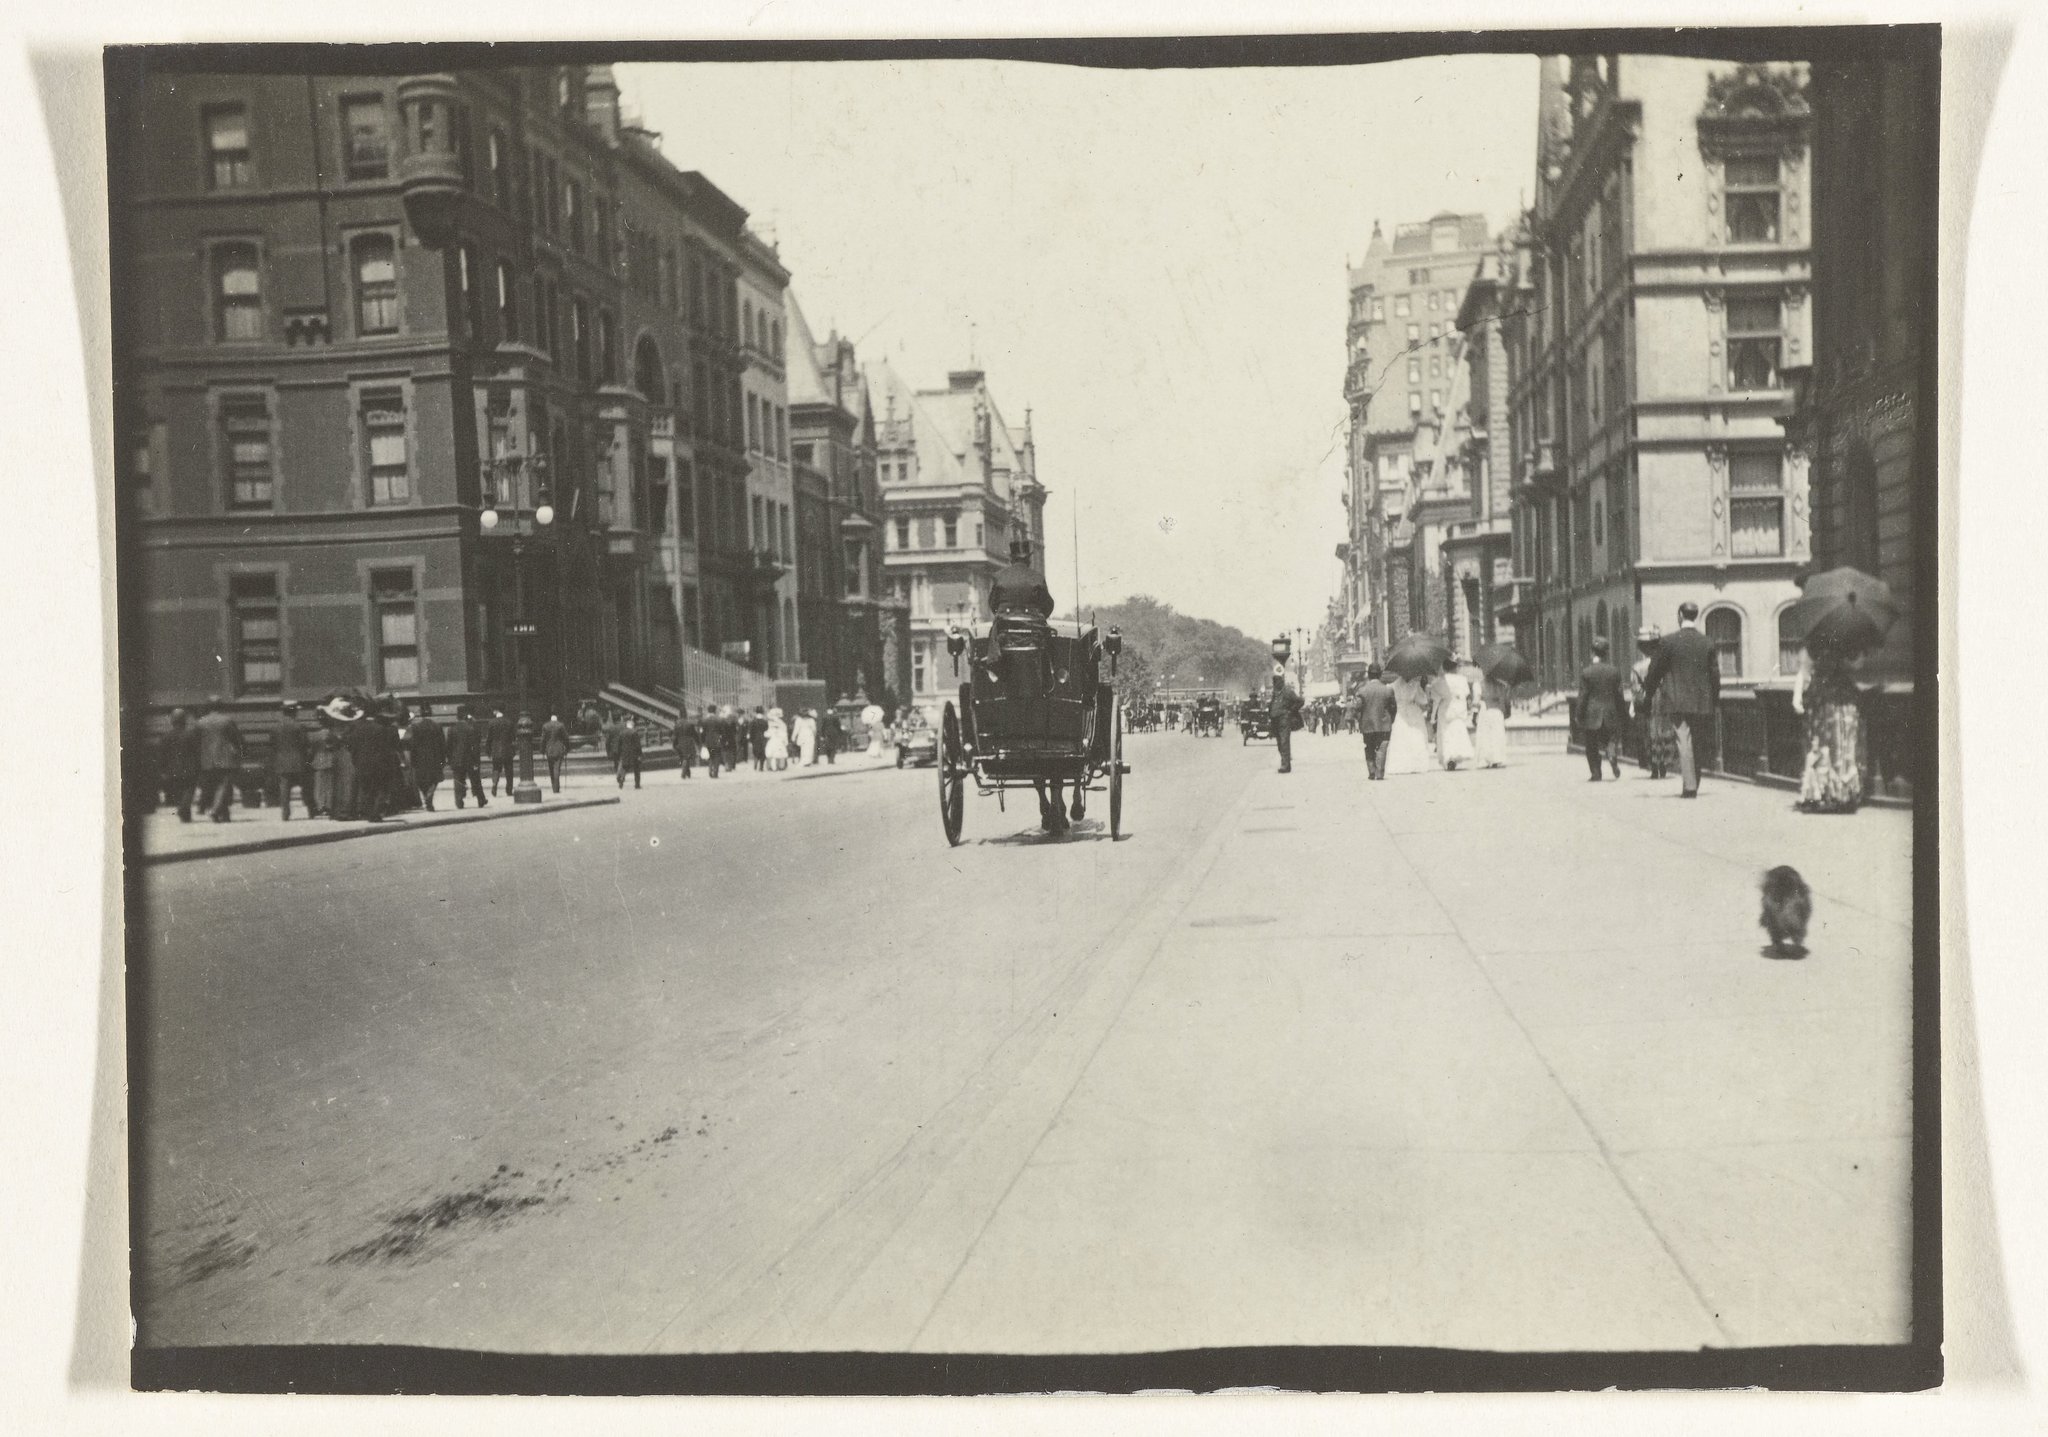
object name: photograph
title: 5th Avenue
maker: geldolph adriaan kessler (dolph)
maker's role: fotograaf, industrieel, voetballer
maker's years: 1884-1945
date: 1905-1908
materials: cardboard, photographic support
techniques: gelatin silver print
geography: new york city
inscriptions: title: ‘5th avenue’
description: Gezicht op 5th Avenue in New York. Onderdeel van het fotoalbum van Dolph Kessler met opnamen die hij maakte tijdens zijn verblijf in Engeland en op een wereldreis die hij als secretaris van Henri Deterding (directeur Koninklijke Olie) ondernam naar Nederlands-Indië, Japan, China en de Verenigde Staten, tussen 1906 en 1908.